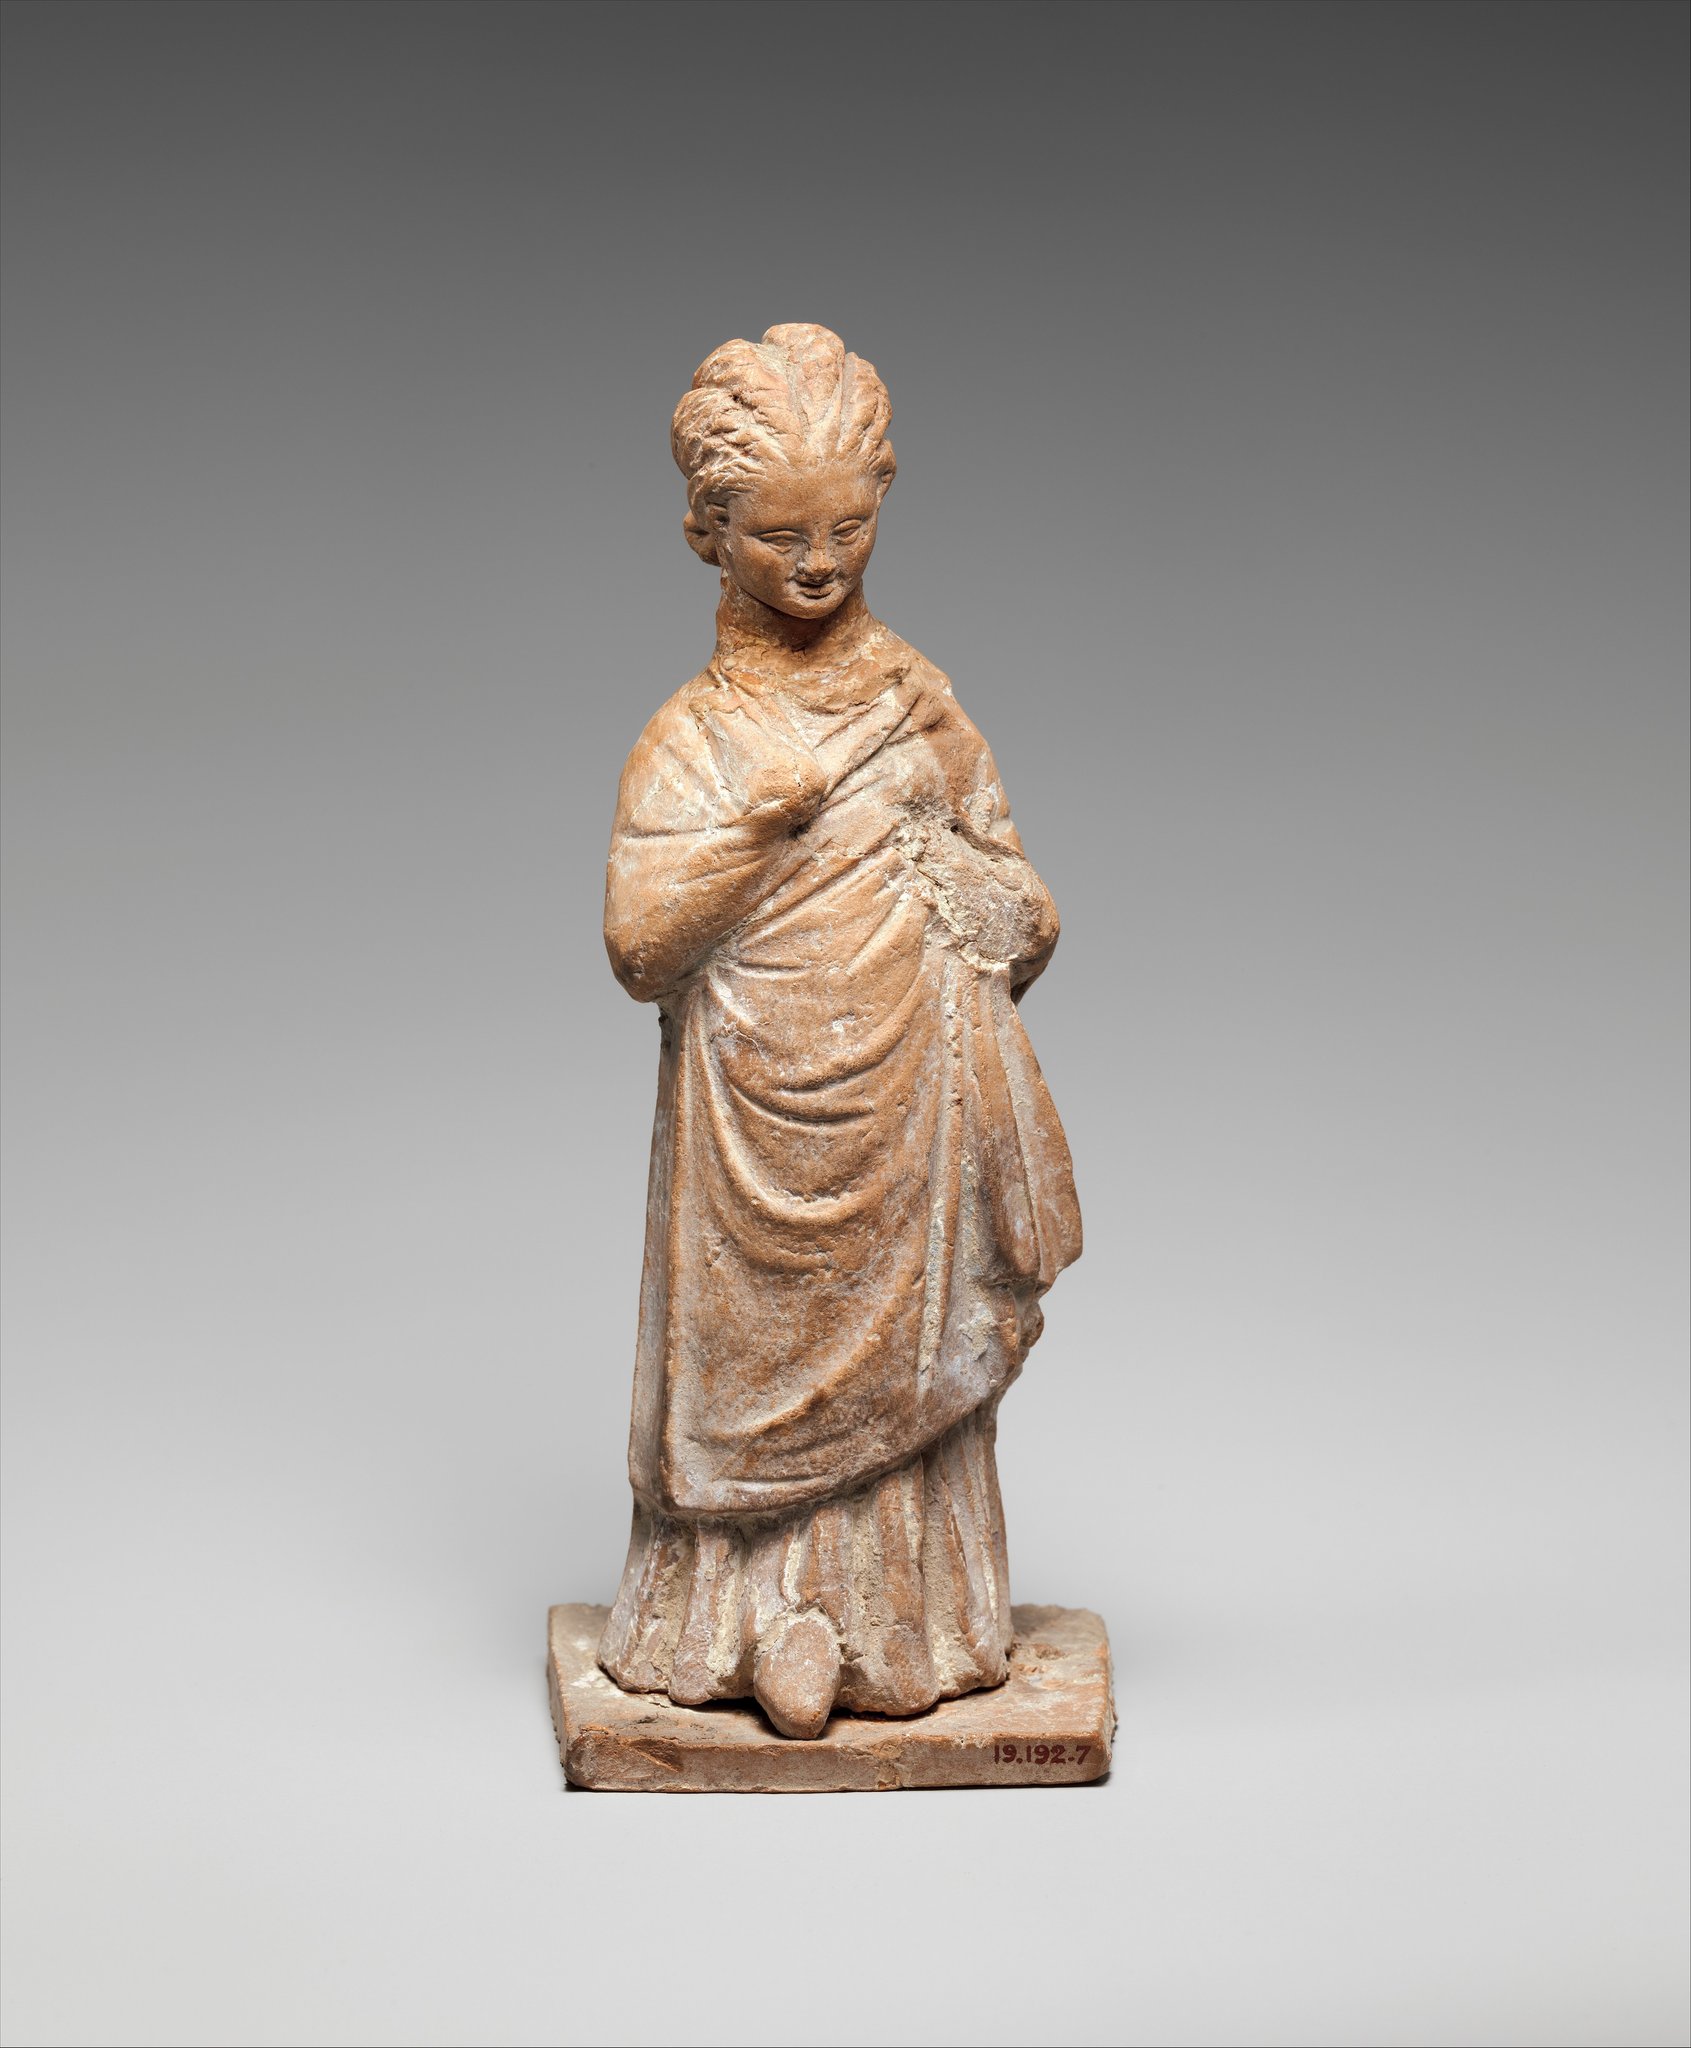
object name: statuette of standing draped girl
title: Terracotta statuette of a standing girl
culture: greek, boeotian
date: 300-268 BCE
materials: terracotta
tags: girls